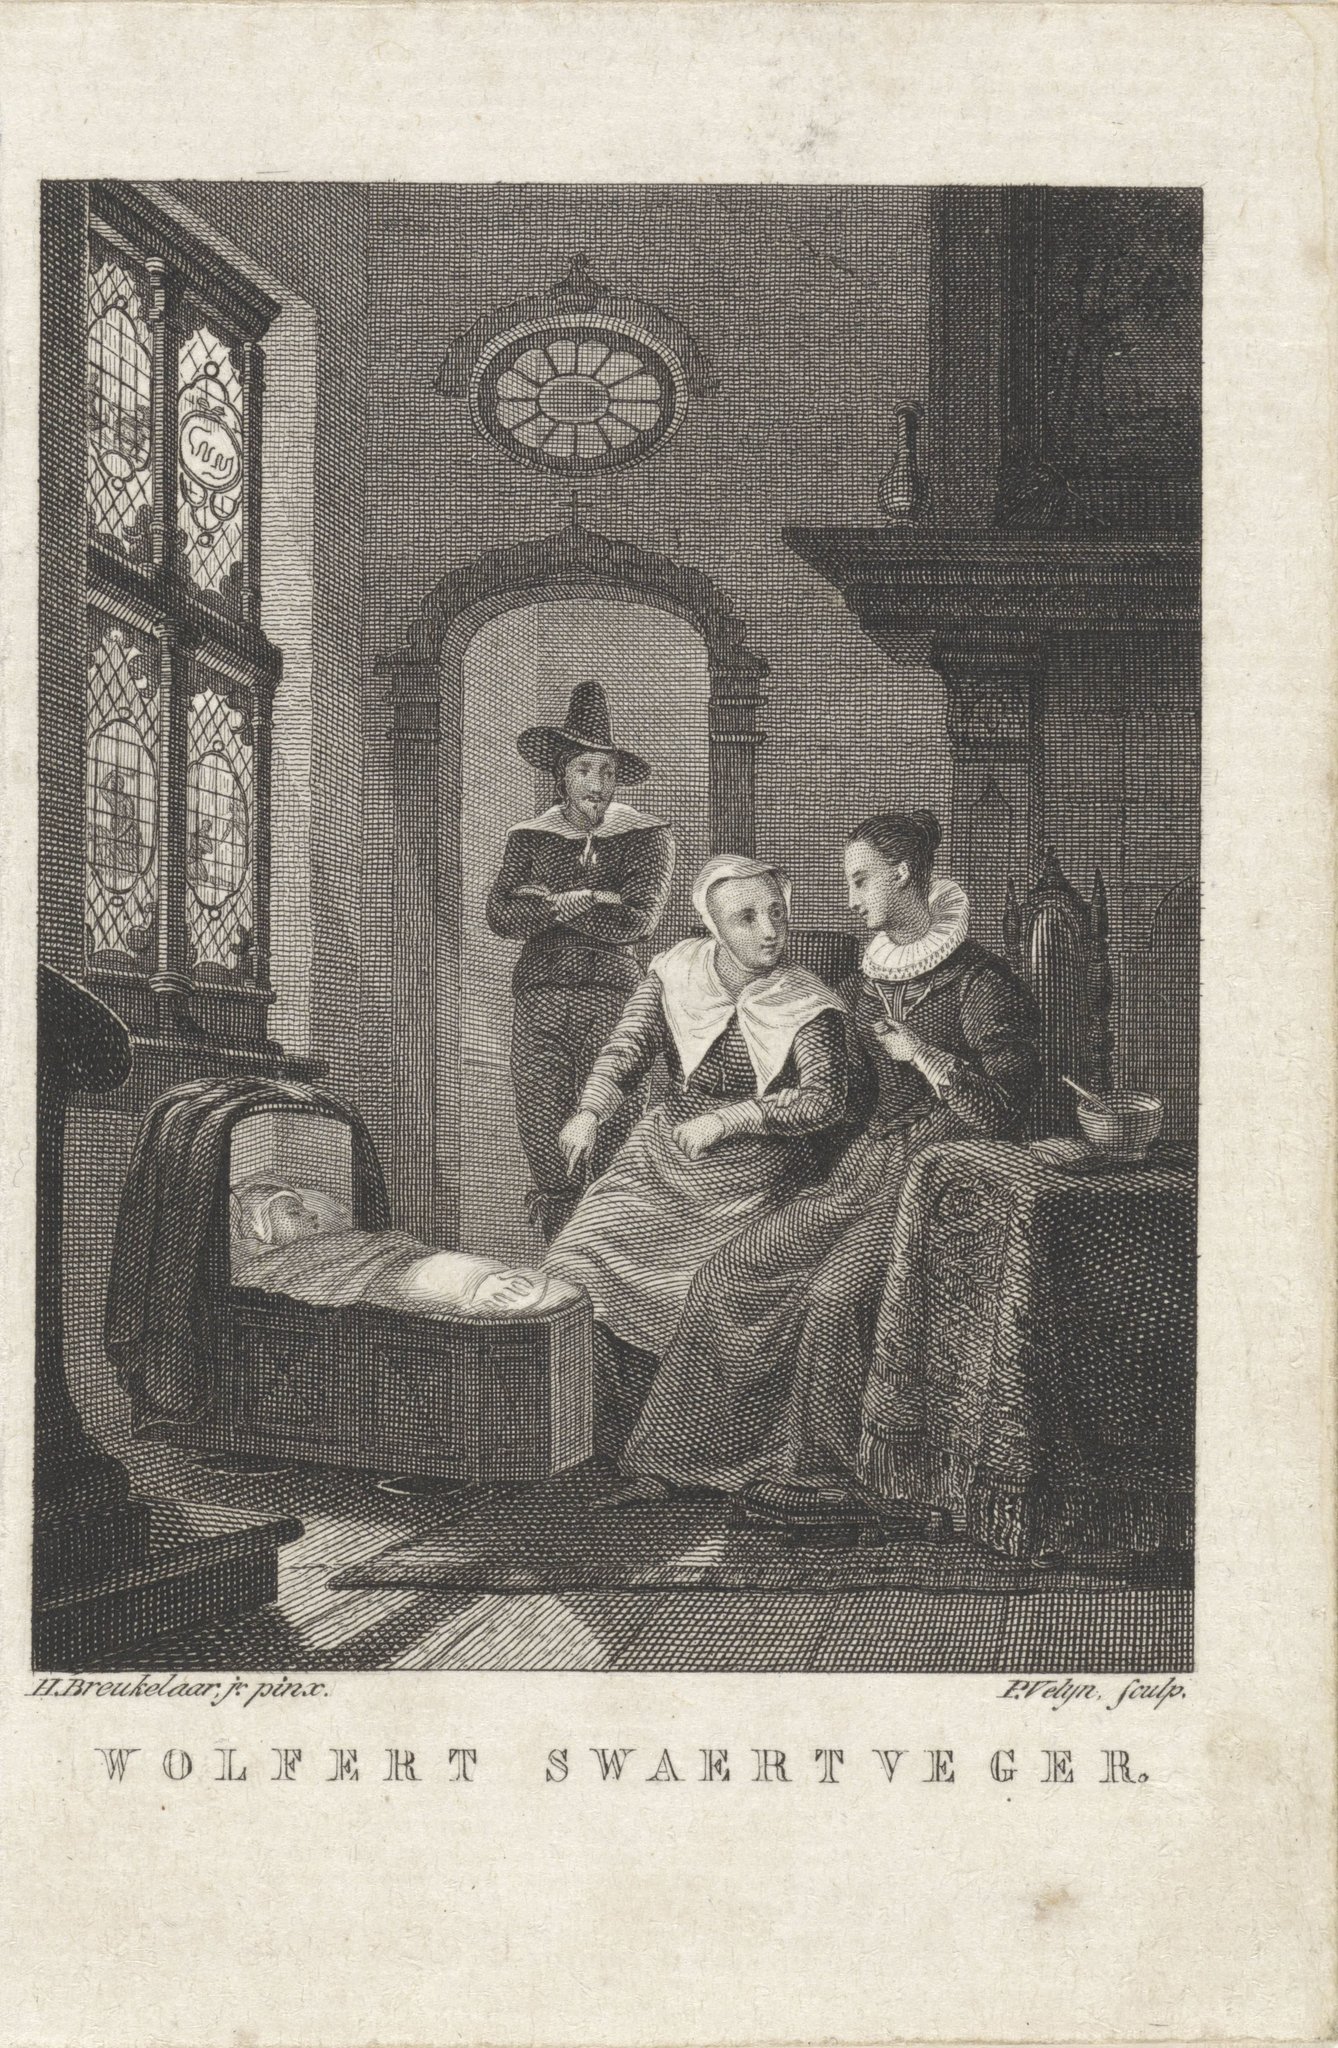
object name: print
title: Wolfert Swaertveger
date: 1832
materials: paper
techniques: engraving, etching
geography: netherlands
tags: arms crossed, interior of the house, cradle, crib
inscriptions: collector's mark: Lugt 2228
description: Prent ook gebruikt als boekillustratie in: Almanak voor het schoone en goede. Amsterdam: G.J.A. Beijerinck, 1832.